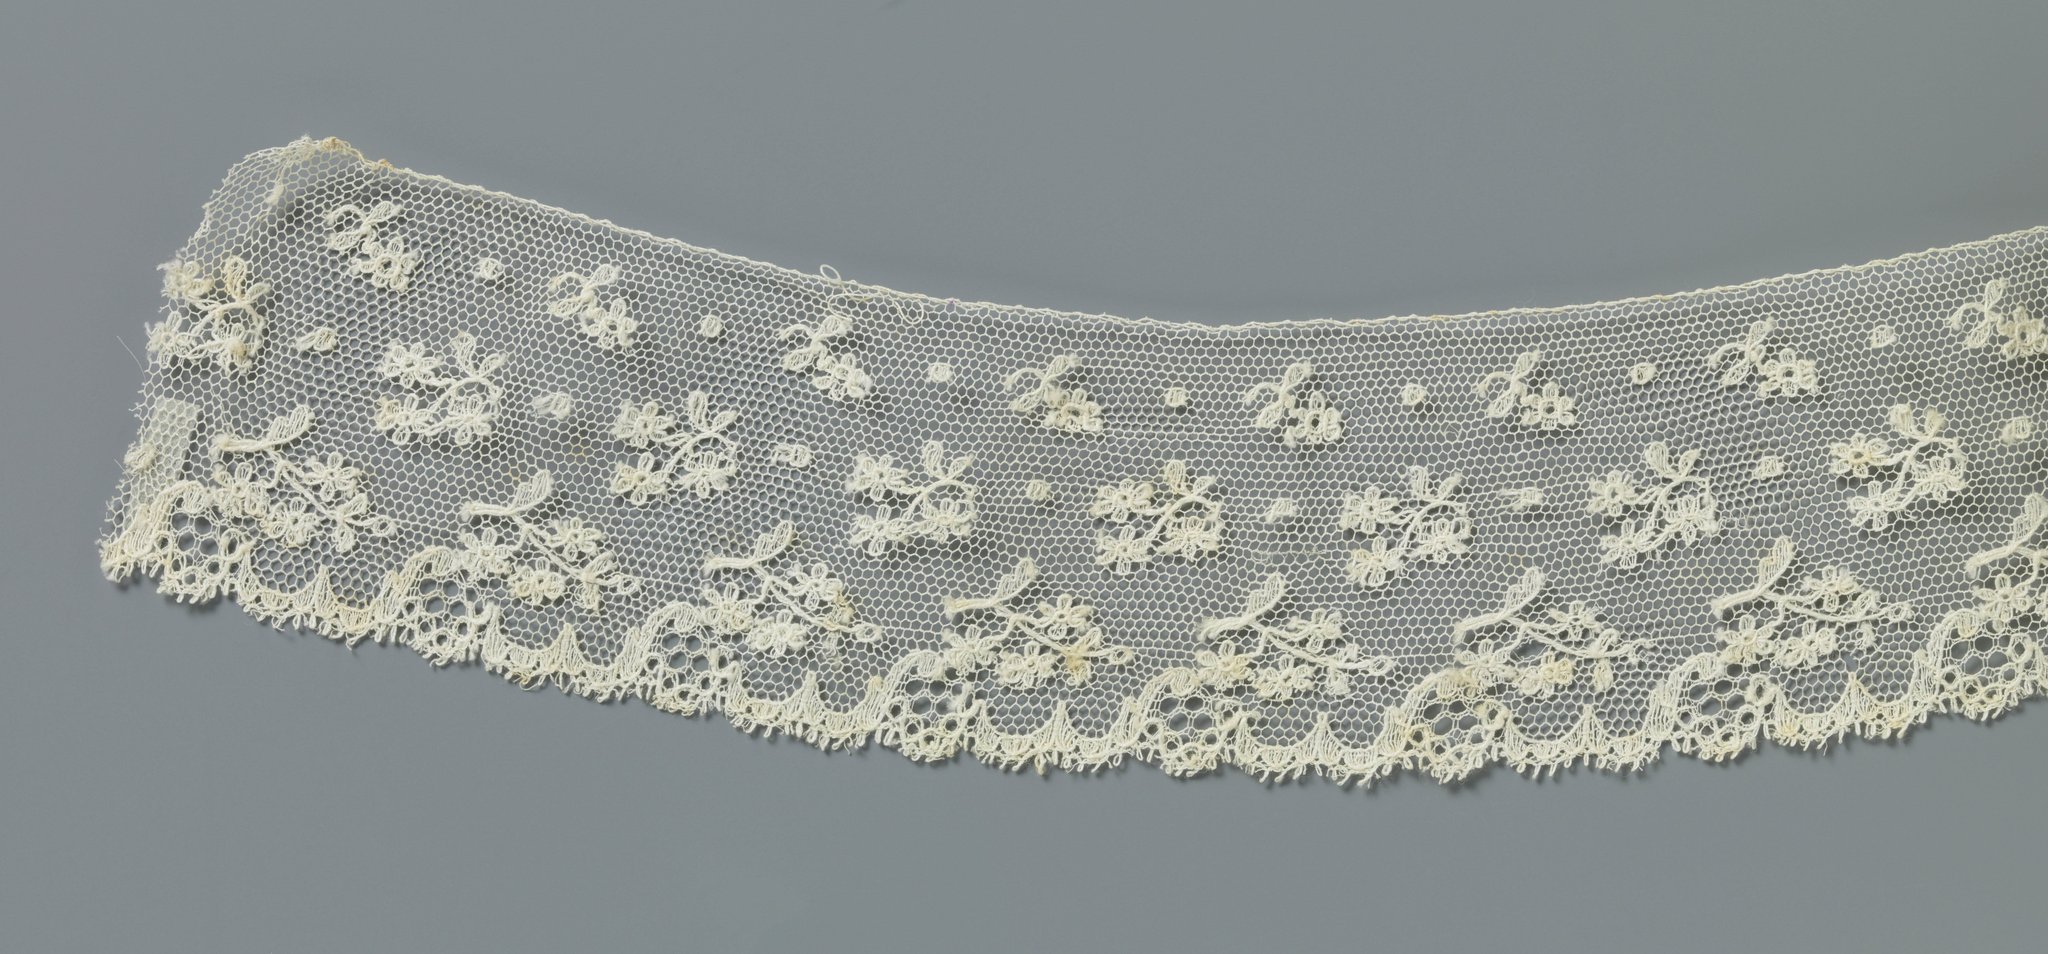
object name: strip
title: Strook machinale kant met drie rijen bloemtakken en w-vormige motiefjes langs de onderzijde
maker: Anonymous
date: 1850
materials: cotton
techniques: lace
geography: france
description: Strook naturelkleurige machinale kant: machinale Alençon-kant. De strook is iets gebogen van vorm. Het zich herhalende patroon bestaat uit drie rijen bloemtakken met steeds één moesje tussen de bloemtakken in de bovenste twee rijen. De opeenvolgende bloemtakken in de bovenste rij bestaan uit één bloem met twee blaadjes. In de middelste rij hangen er steeds drie bloemen aan de bloemtakken. De onderste bloemtakken zijn het grootst met drie bloemen en een bloemknop in de top. Langs de onderrand liggen w-vormige motiefjes waartussen cirkeltjes gemaakt met een siergrond, een machinale rozengrond. De motieven zijn voorzien van contourdraden en zijn met elkaar verbonden door een zeshoekige maasgrond, een machinale Alençon-grond. De bovenzijde van de strook is recht afgewerkt. De flauw geschulpte onderzijde komt voort uit het patroon met de w-vormige motiefjes en cirkeltjes en is afgewerkt met picots.